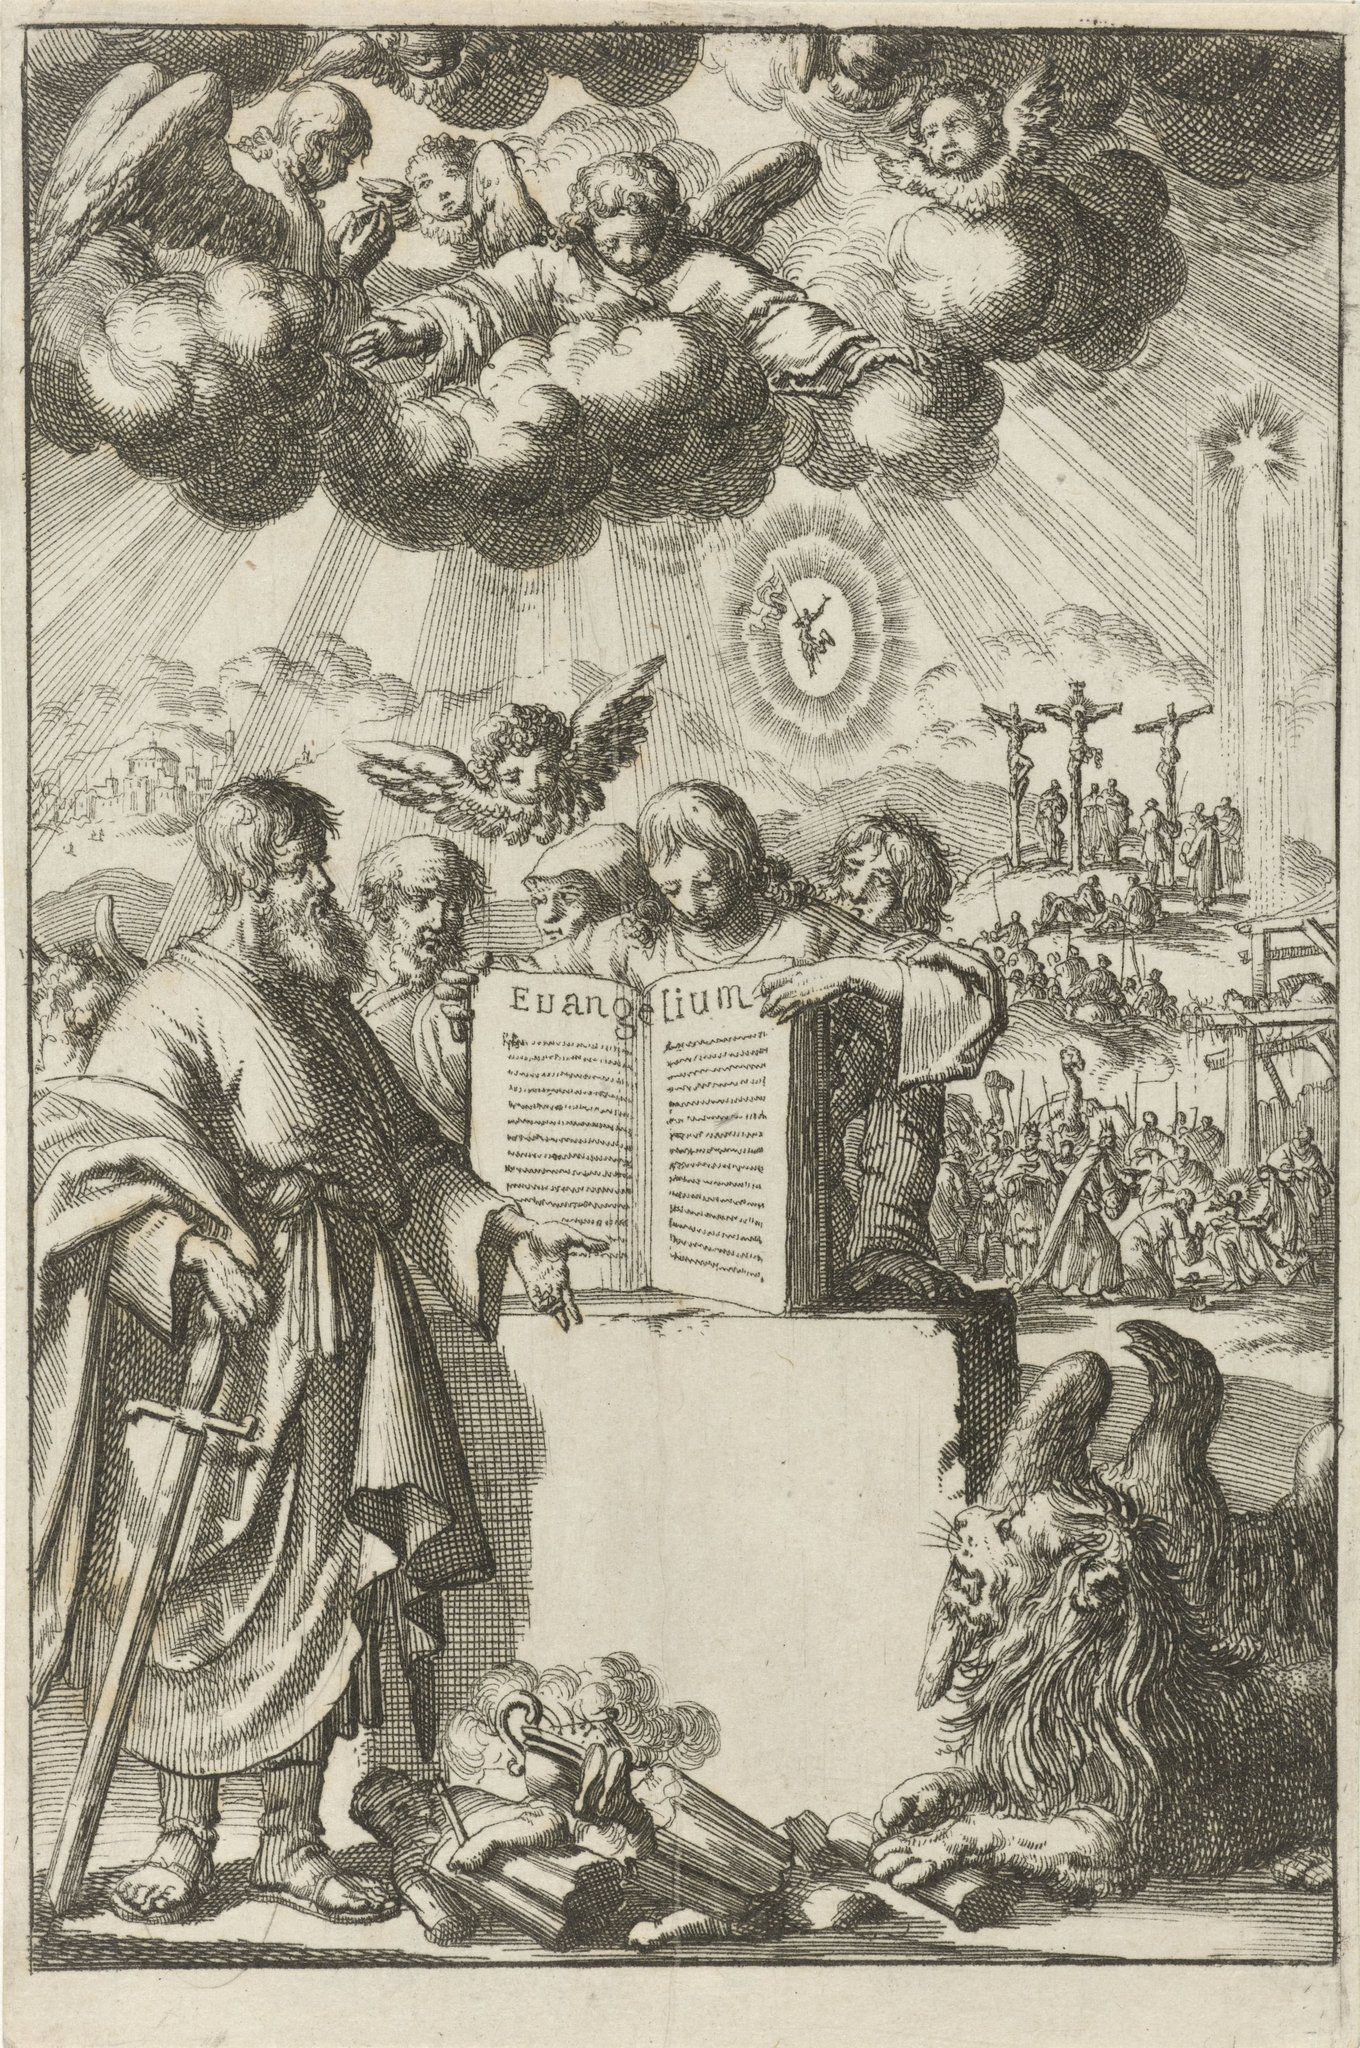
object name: print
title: Johannes toont Paulus het evangelie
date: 1688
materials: paper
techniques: etching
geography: amsterdam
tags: the four evangelists ~ other themes, adoration of the kings: the wise men present their gifts to the christ-child (gold, frankincense and myrrh), resurrection of christ, the crucifixion of christ: christ's death on the cross; golgotha (matthew 27:45-58; mark 15:33-45; luke 23:44-52; john 19:25-38), the apostle paul of tarsus; possible attributes: book, scroll, sword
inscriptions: collector's mark: Lugt 2228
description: Johannes toont Paulus het evangelie. Achter Johannes staan de drie andere evangelisten Matteüs, Marcus en Lucas. In de verte de aanbidding der wijzen, de kruisiging en de opstanding van Christus.